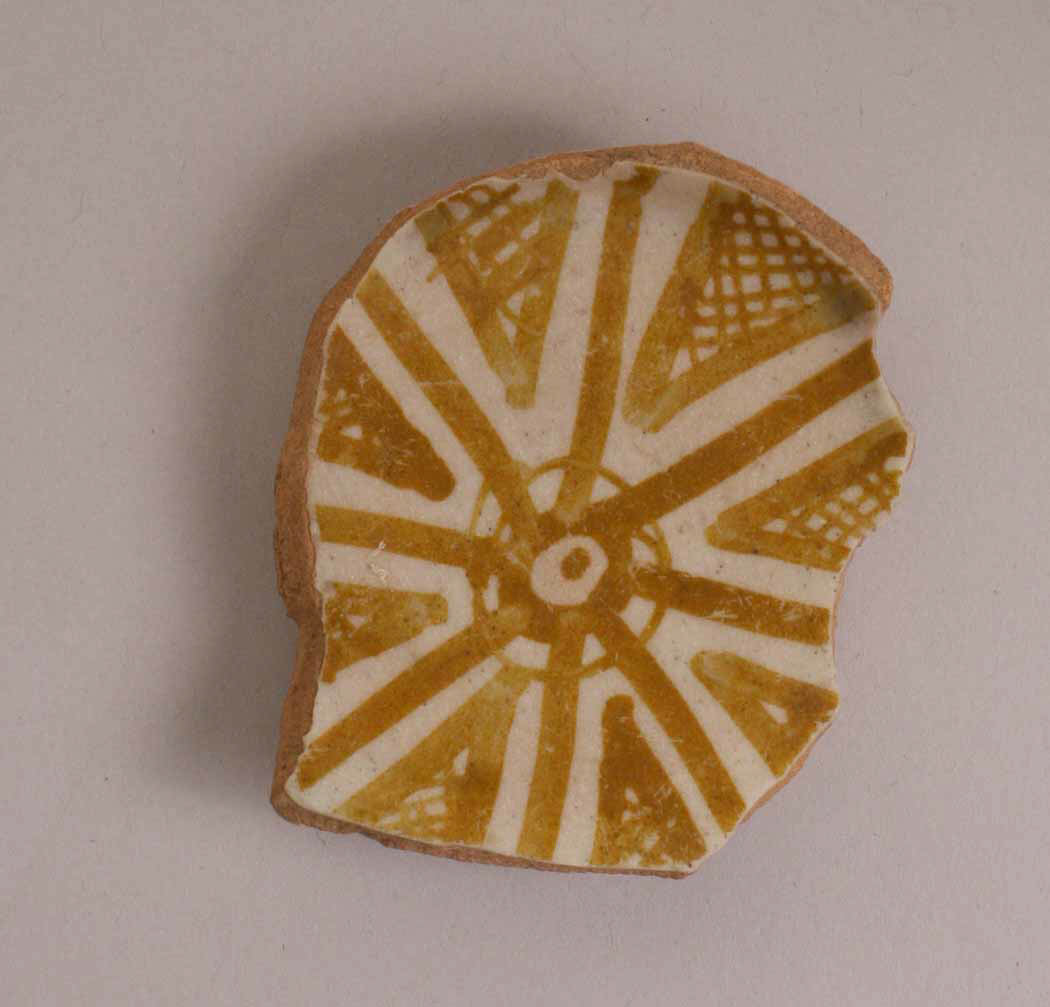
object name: ceramic fragment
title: Fragment of a Bowl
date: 1201-1400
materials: earthenware, glaze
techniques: luster painting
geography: egypt